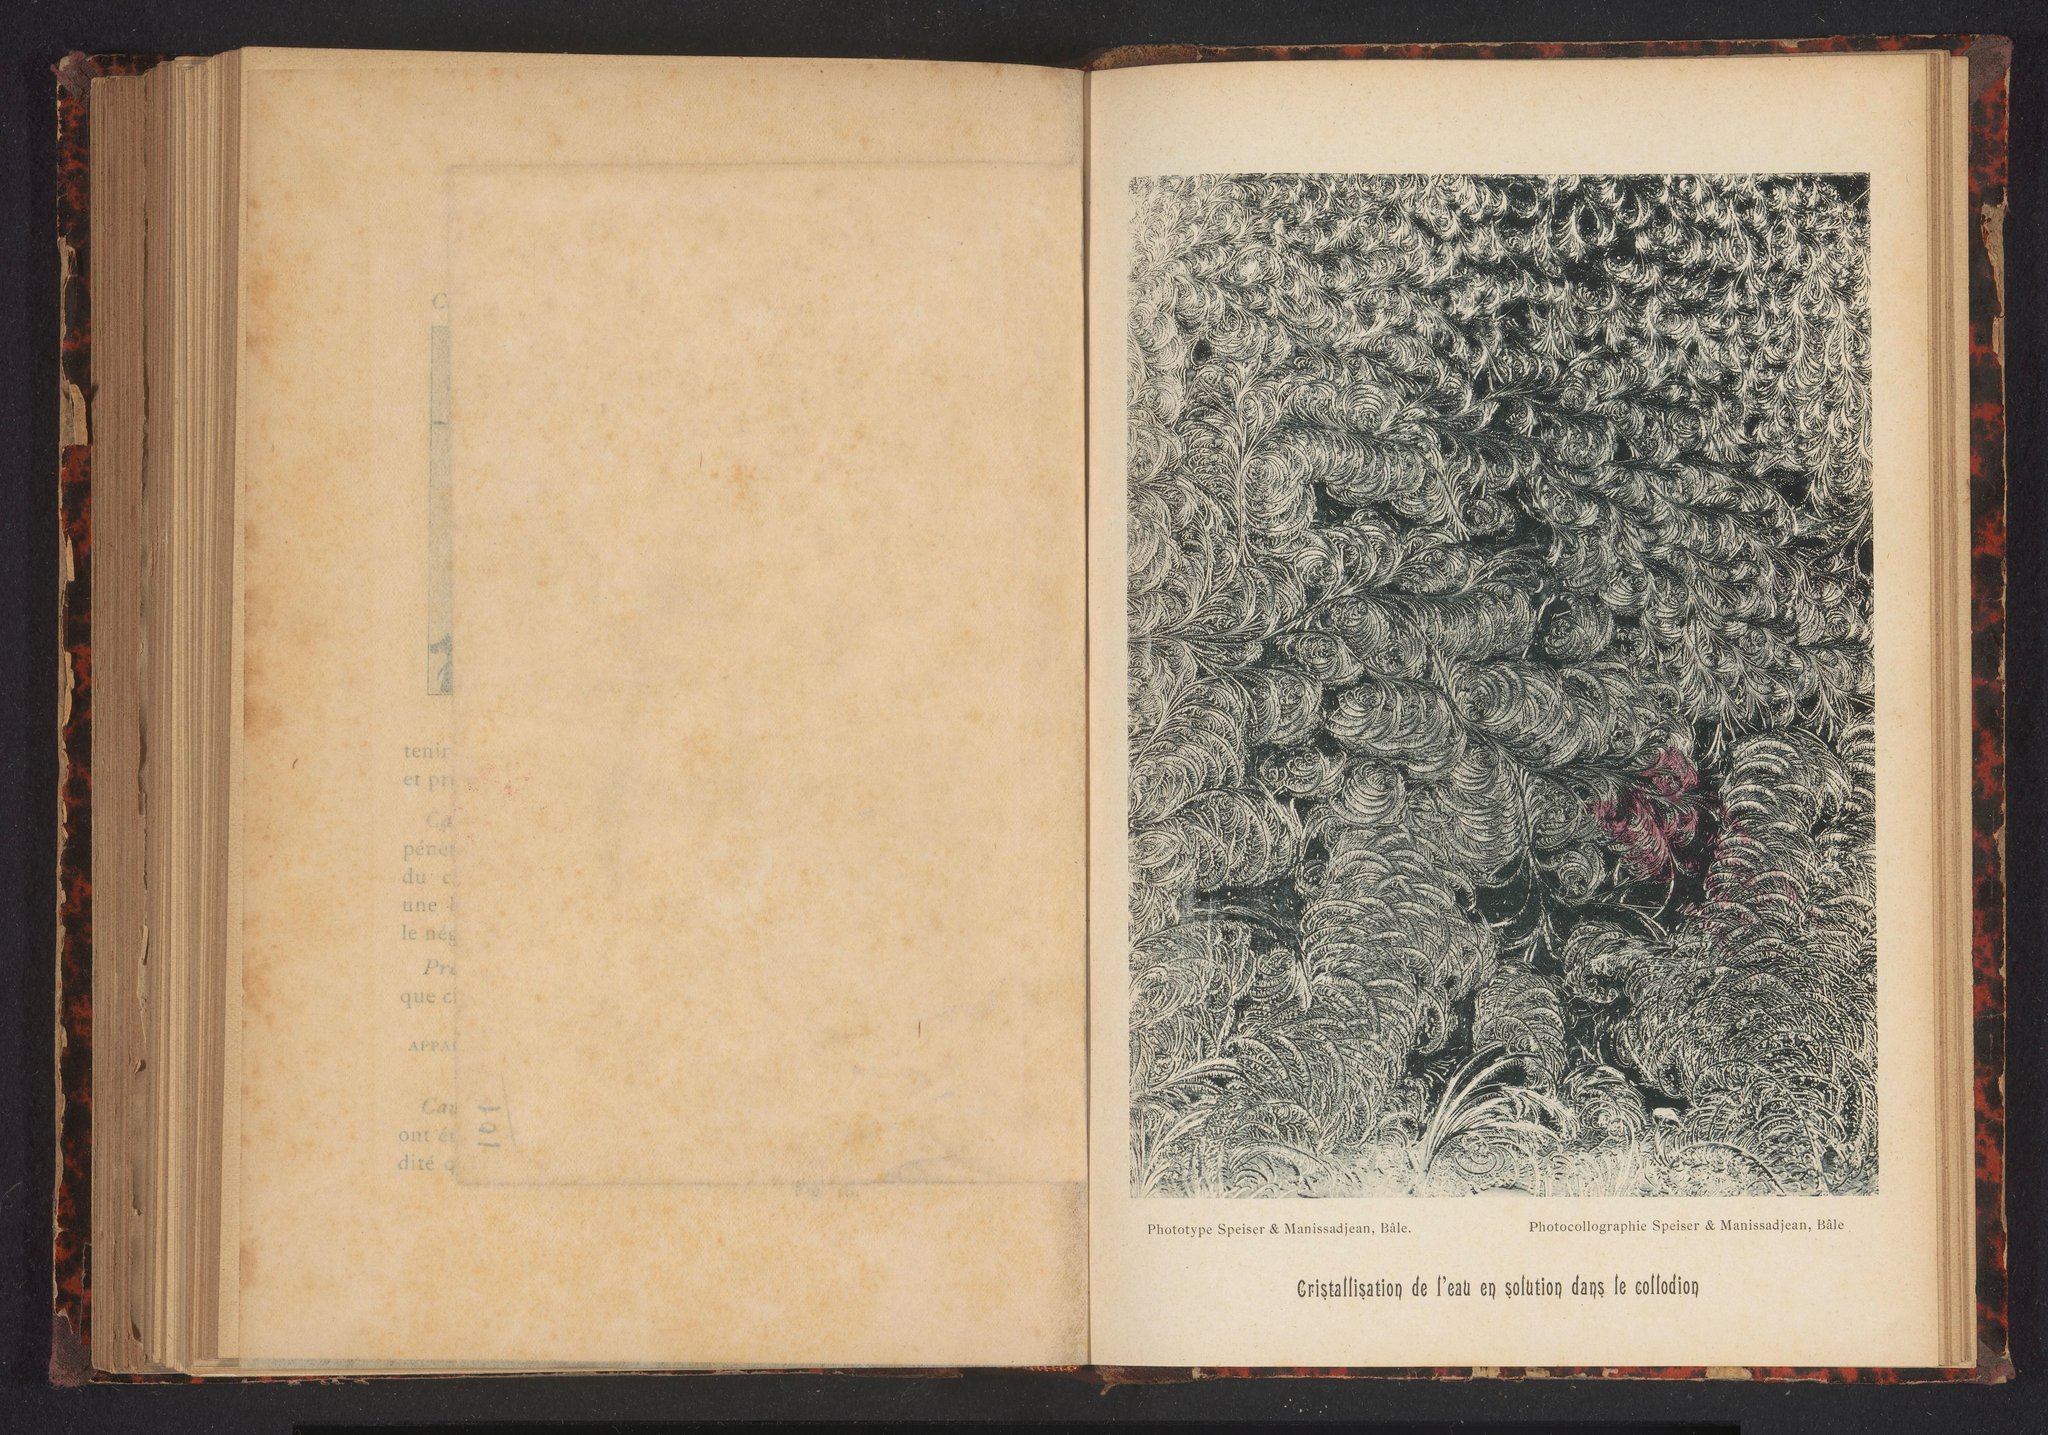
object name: page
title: Cristallisation de l'eau en solution dans le collodion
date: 1895-1900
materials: paper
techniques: photograph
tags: birds (+ feathers)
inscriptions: collector's mark: ‘[...]’